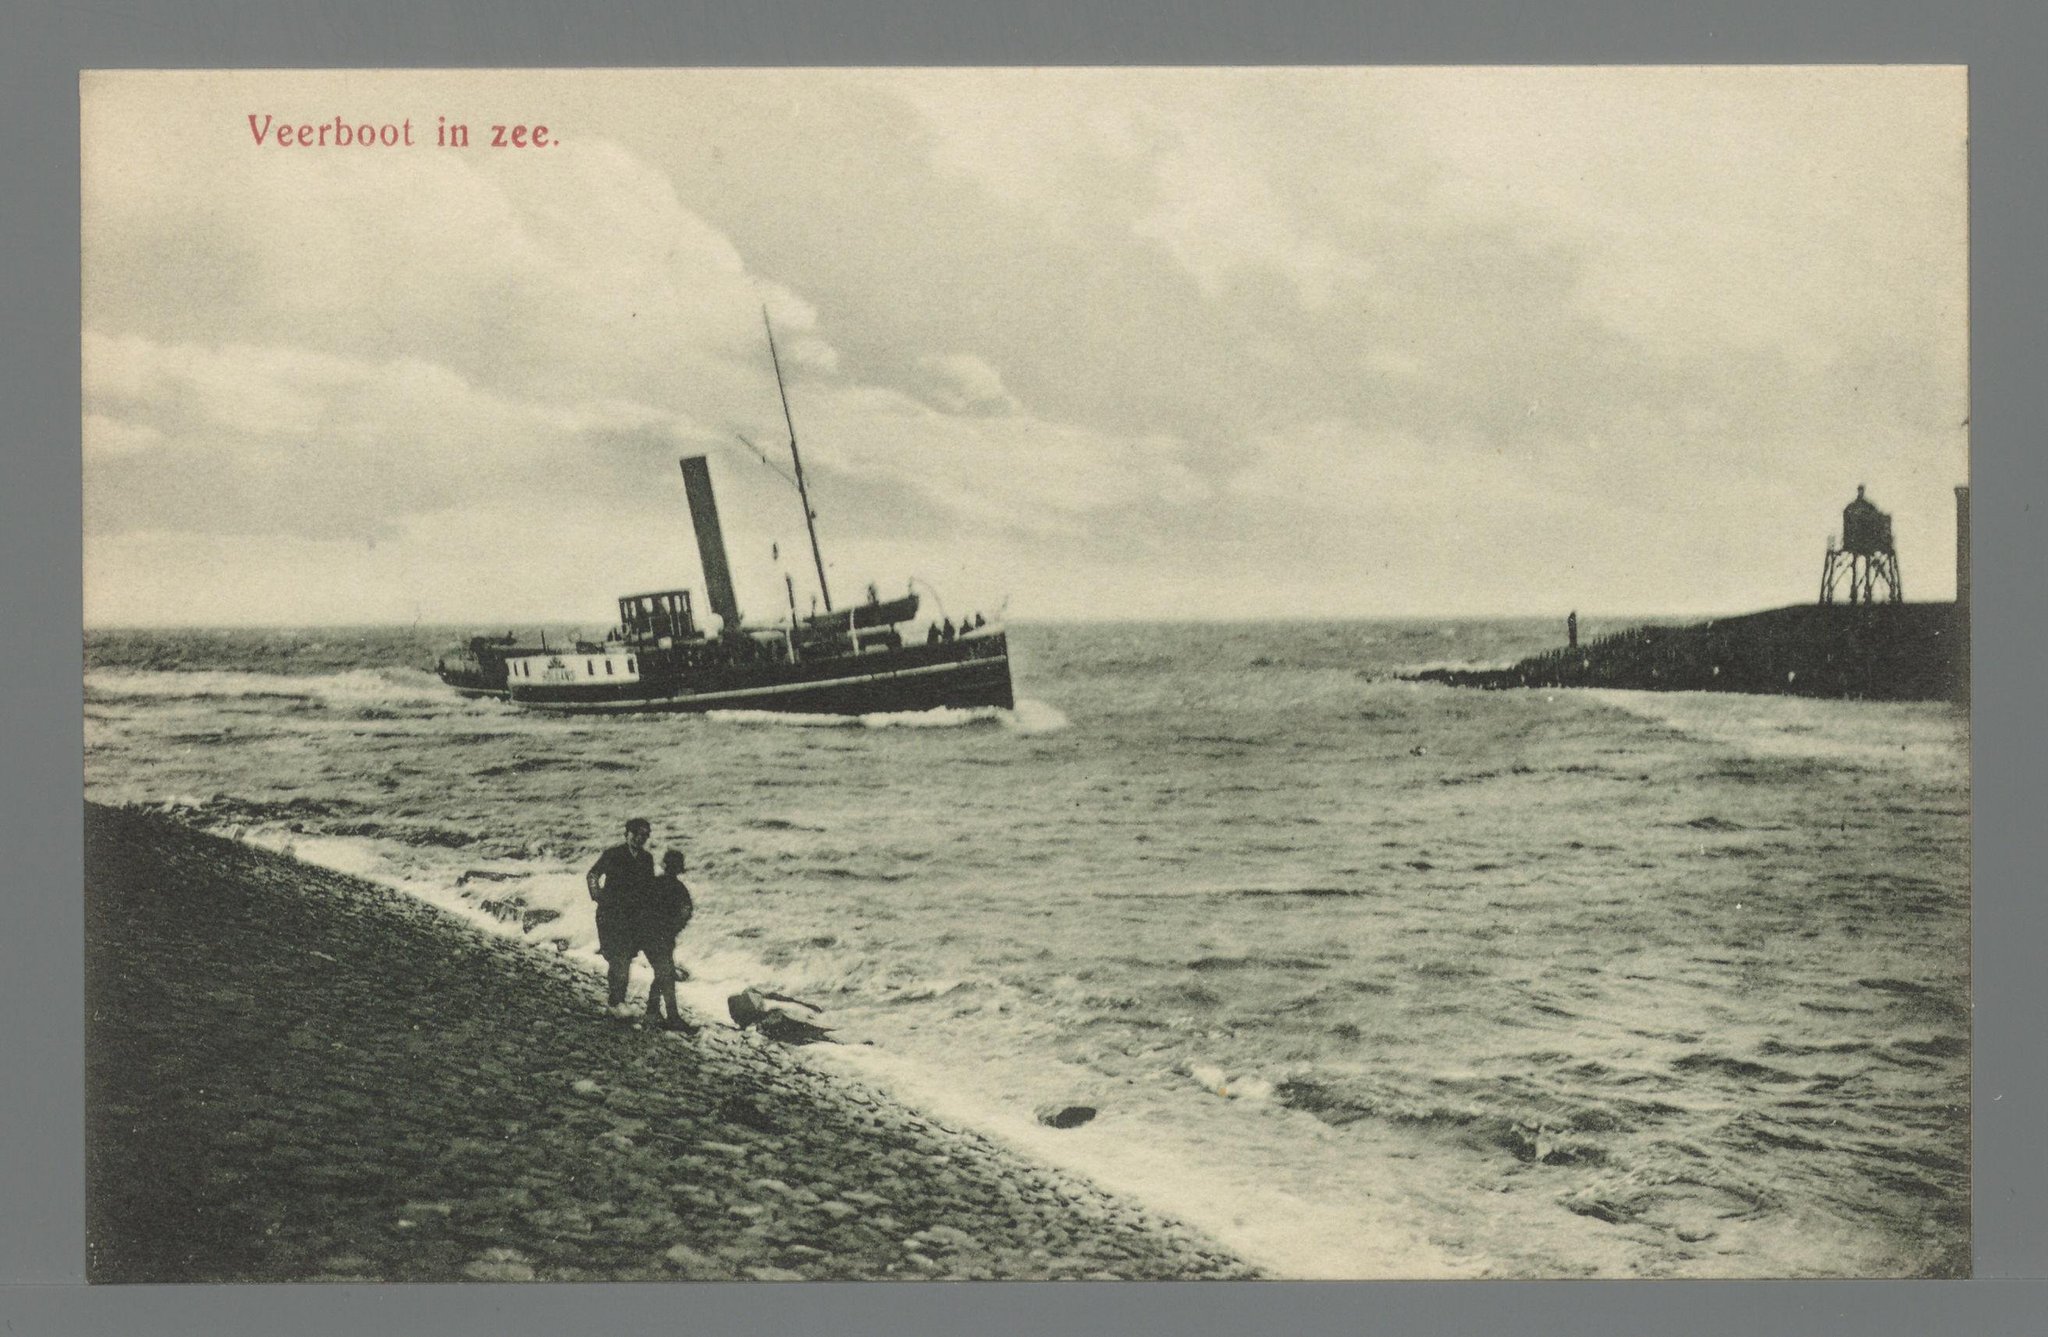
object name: photomechanical print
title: Veerboot in zee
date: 1905-1930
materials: cardboard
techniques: photograph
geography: stavoren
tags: harbour, ferry, sea